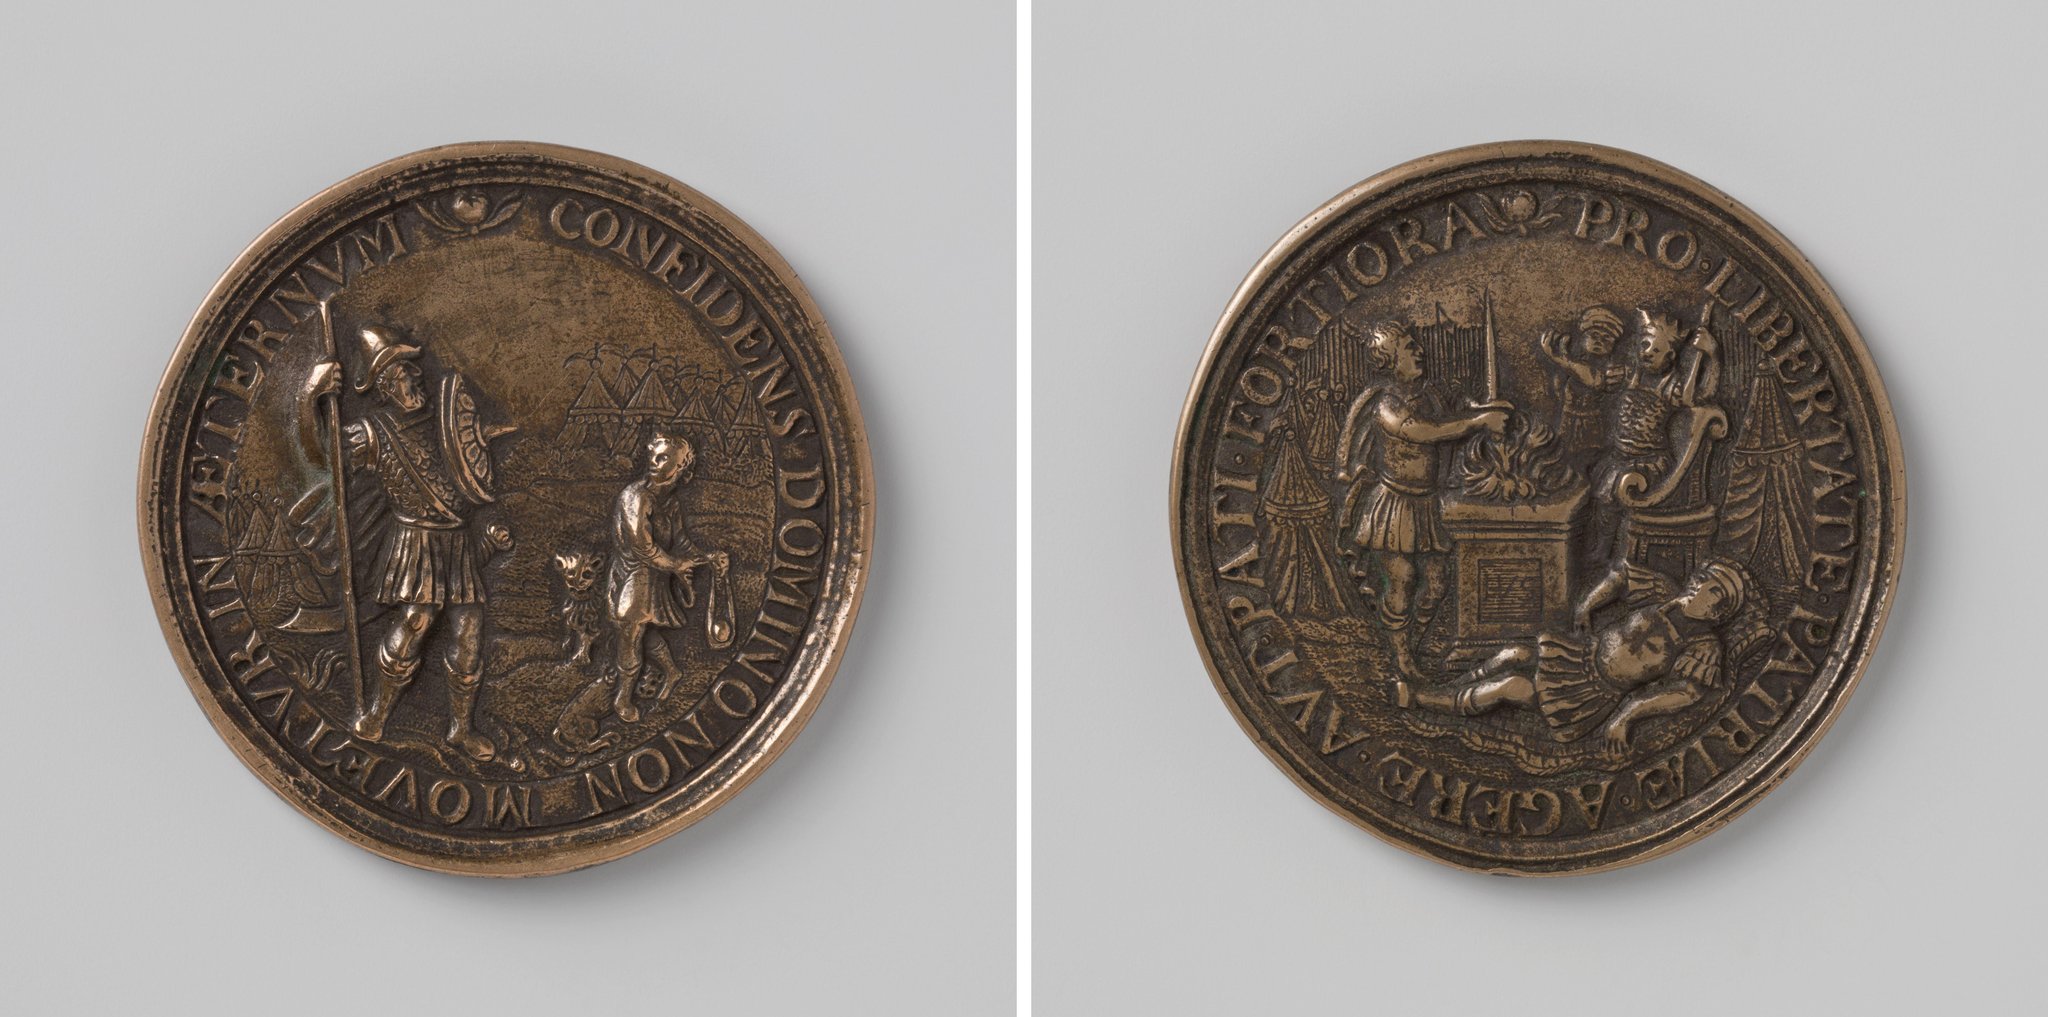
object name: history medal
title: Plechtige ontvangst van Willem I, prins van Oranje-Nassau in Brabant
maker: Anonymous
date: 1600-1800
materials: copper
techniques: striking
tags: delft, william i (prince of orange), brabant